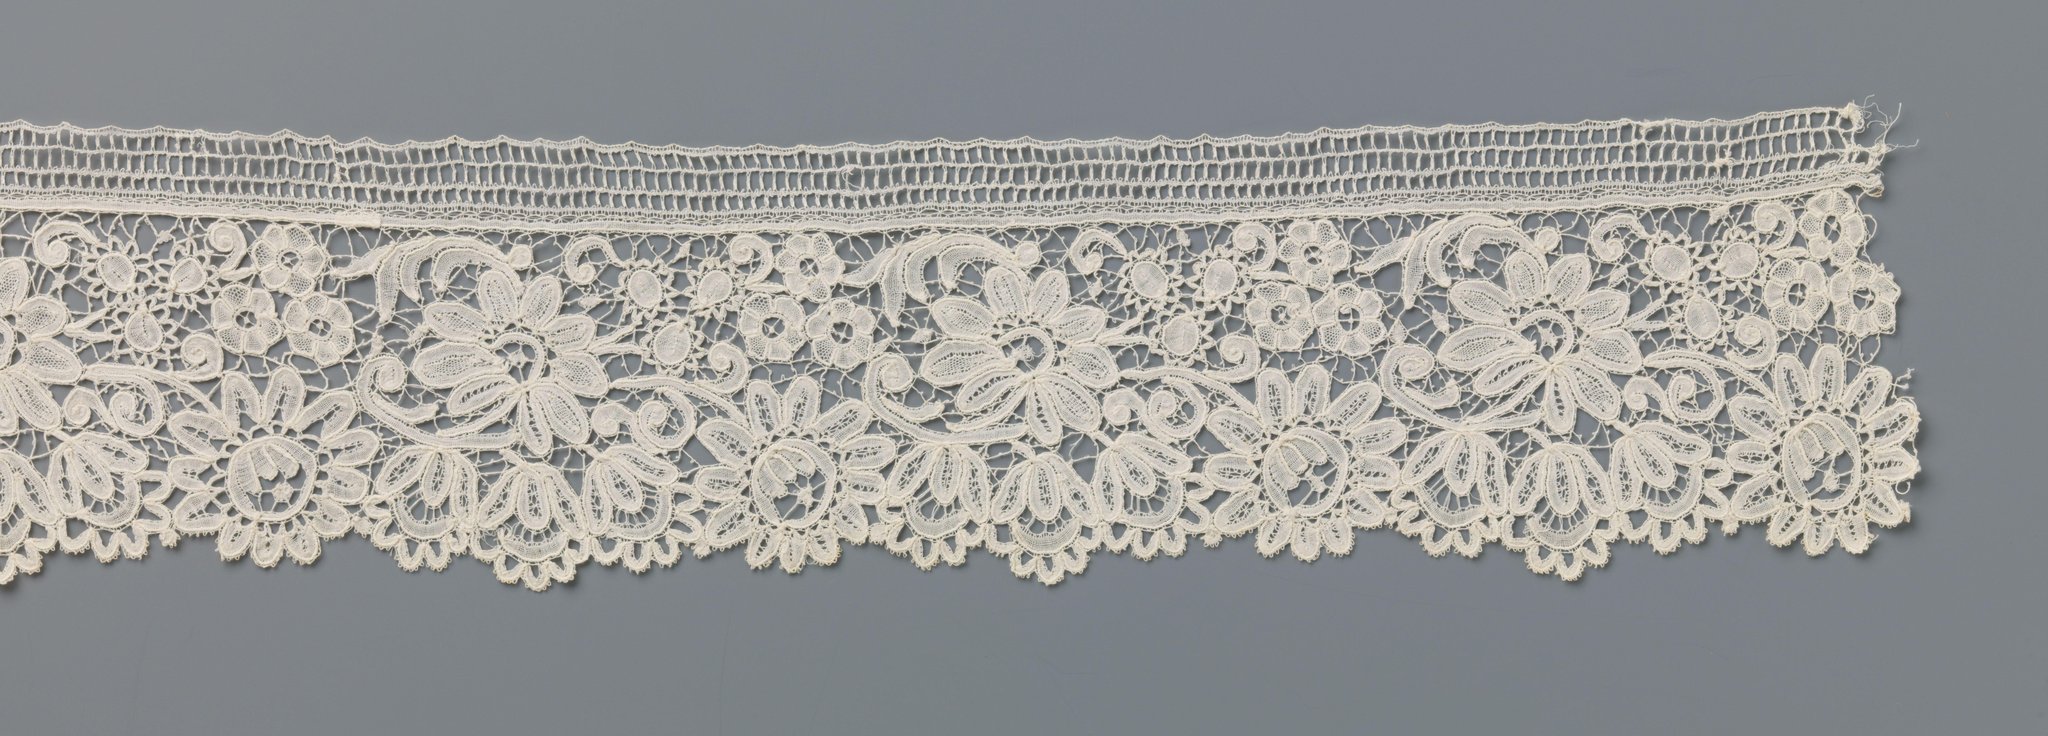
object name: strip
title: Strook kloskant met drie hangende klokjesbloemen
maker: Anonymous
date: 1875-1899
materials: linen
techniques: lace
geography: sluis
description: Strook naturelkleurige kloskant, duchesse-kant. Op een spijlenfond staat een gesloten patroon van een dunne voluutrank, waaraan een margriet en een in de schulpen afhangende anemoon en drie hangende klokjesbloemen.